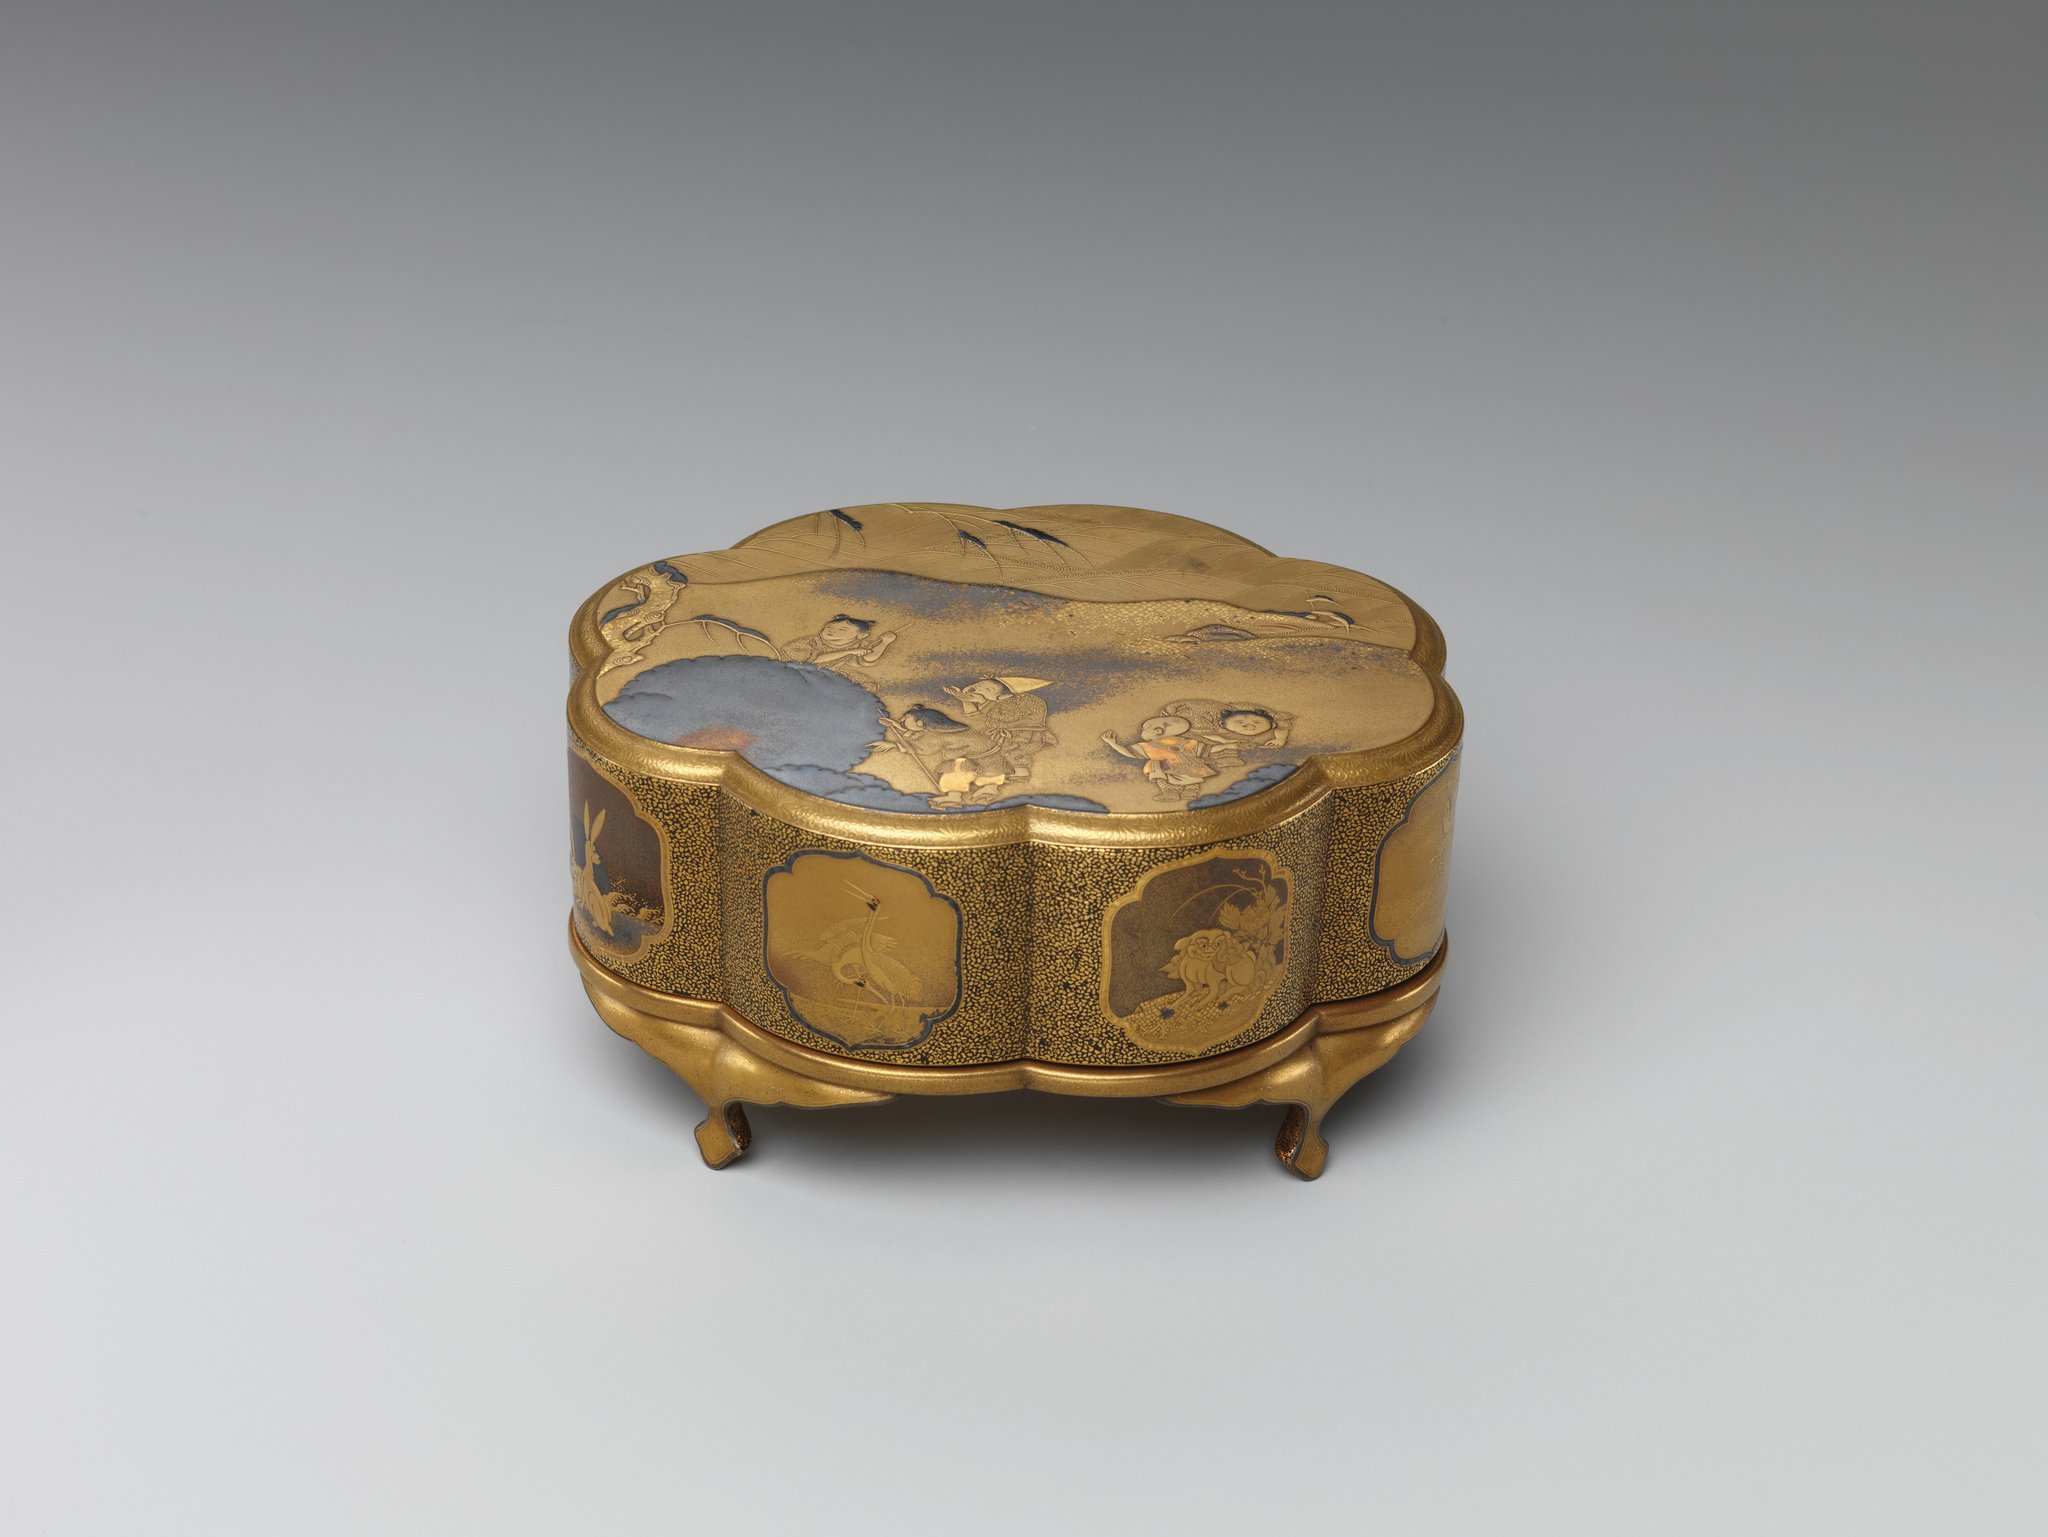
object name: incense box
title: Incense box with Chinese children playing with snowballs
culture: japanese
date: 1701-1800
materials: gold, gold foil, gold leaf, lacquer, silver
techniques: cutting, hiramakie, maki, maki-e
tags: animals,birds,boys,girls,rabbits